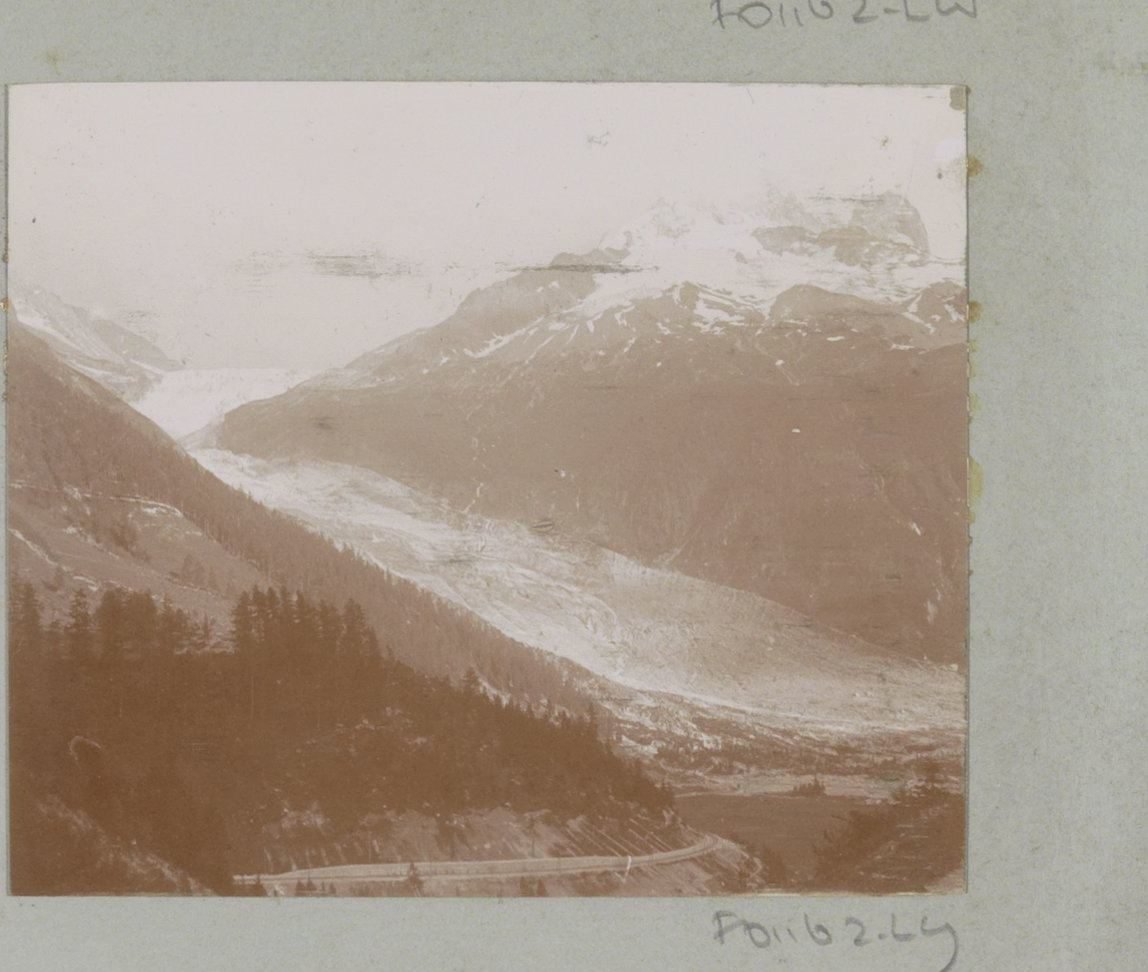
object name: photograph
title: Gezicht op een berg en een gletsjer in de Alpen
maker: Anonymous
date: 1905-1910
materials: paper, photographic support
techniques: gelatin silver print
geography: alps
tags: glacier, mountains (+ landscape with figures, staffage), mountain-range, snow peaks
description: Onderdeel van Fotoalbum van een Franse amateurfotograaf met bezienswaardigheden in Frankrijk, Zwitserland en Italië.